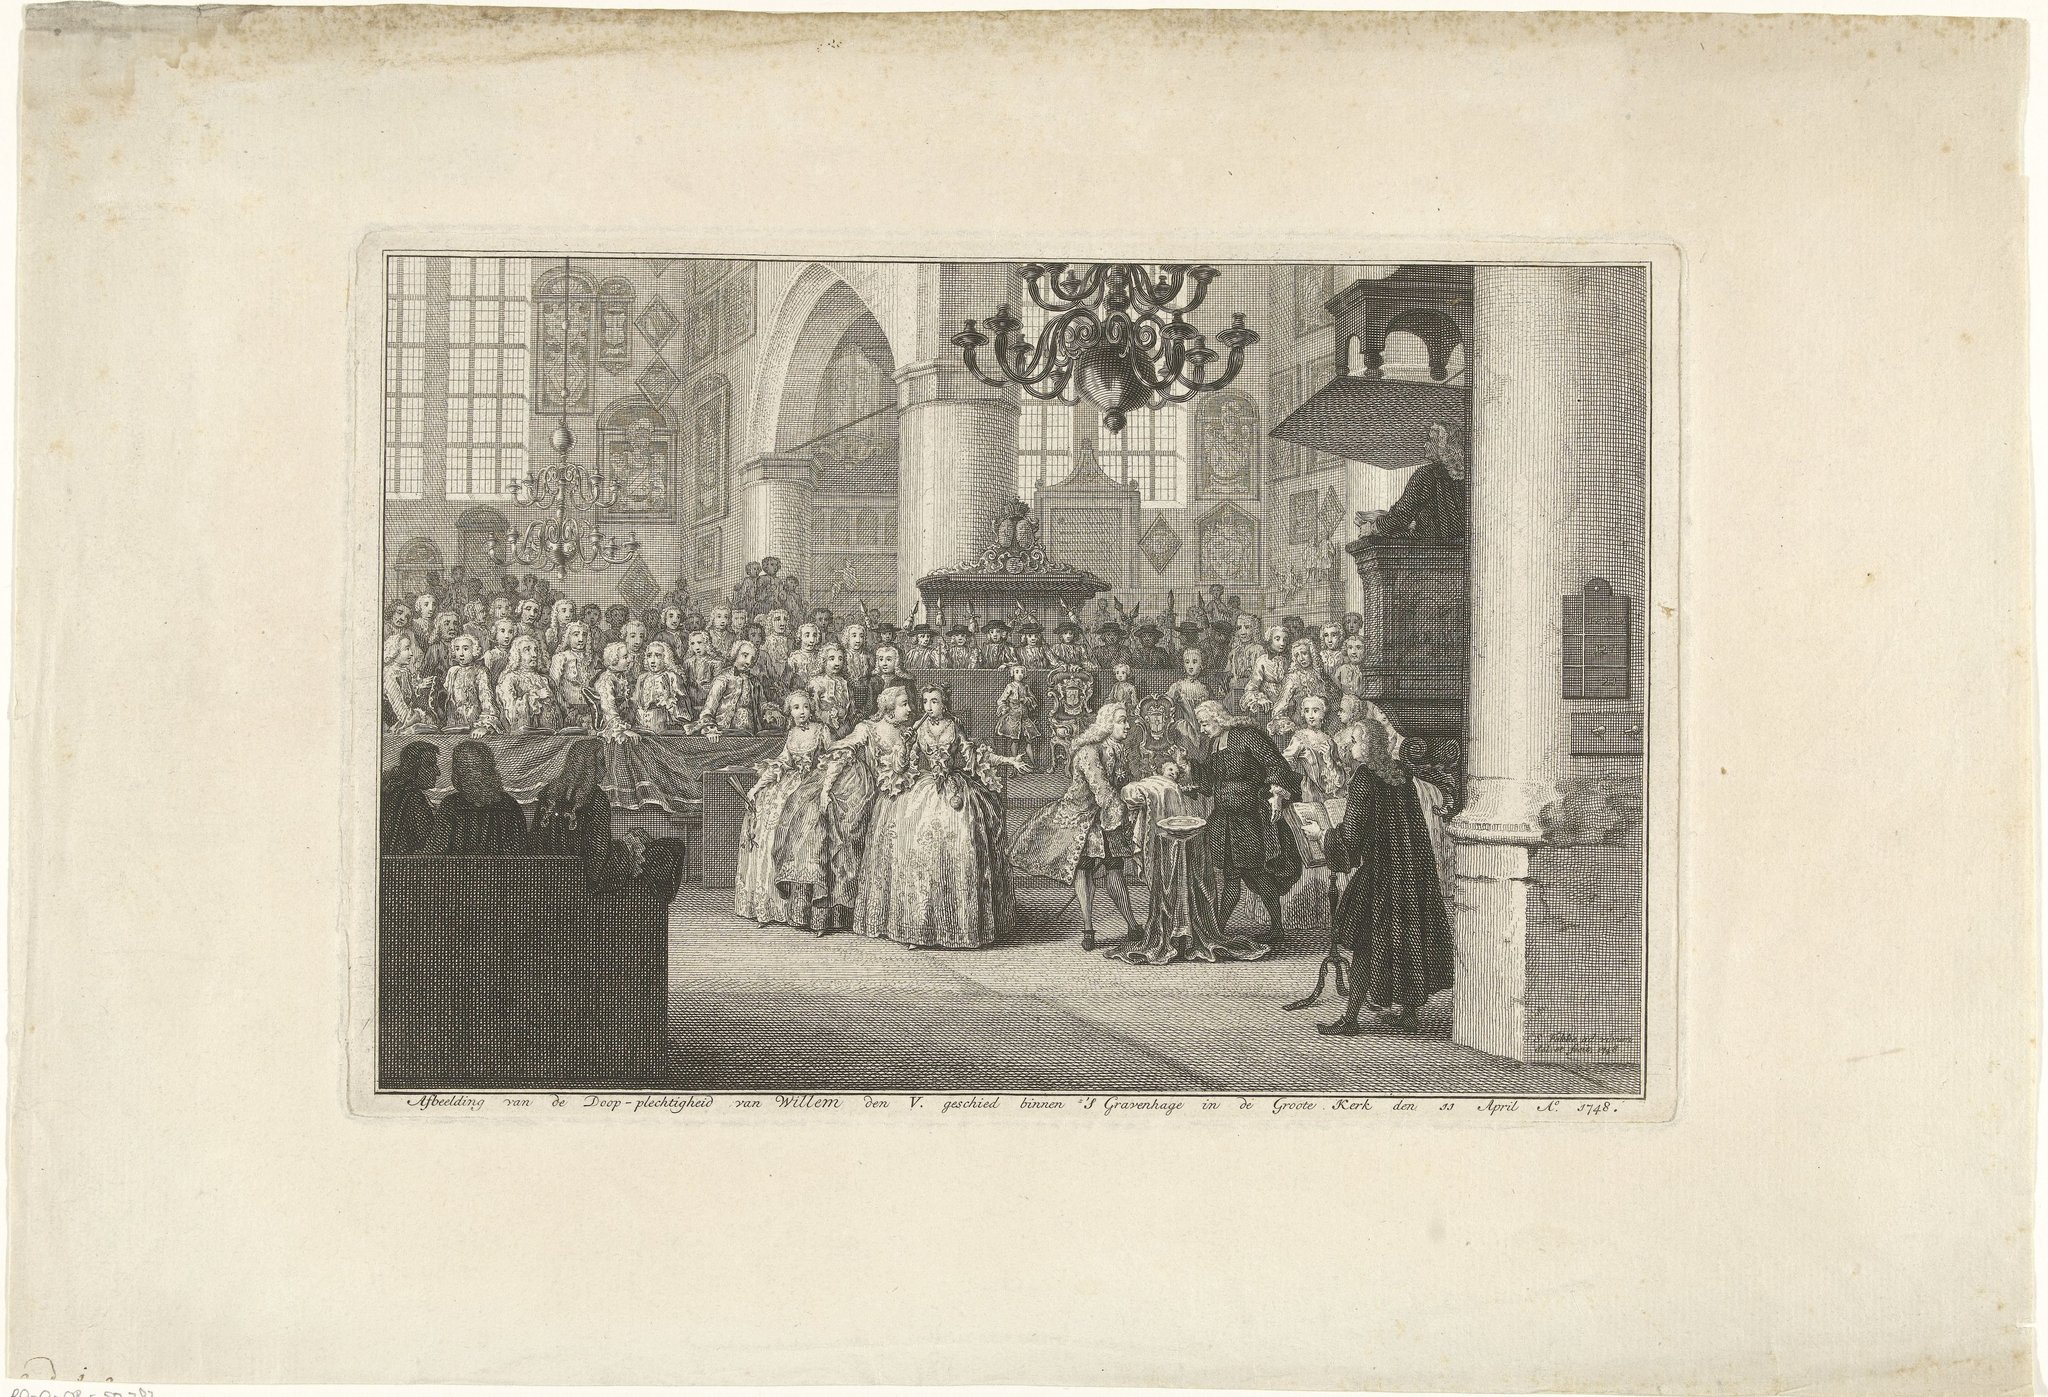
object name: print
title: Doop van prins Willem V, 1748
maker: simon fokke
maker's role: draughtsman, print maker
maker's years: 1712-1784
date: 1748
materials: paper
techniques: engraving, etching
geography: amsterdam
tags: the hague, william v (prince of orange), willem iv (prins van oranje-nassau), anna van hannover, baptism ~ protestant service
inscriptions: collector's mark: Lugt 2228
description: Doopceremonie van prins Willem V in de Grote Kerk te Den Haag, 11 april 1748. Willem IV houdt het kind tijdens het dopen vast, links kijkt de prinses met hofdames toe. Kerkinterieur met vele gasten.